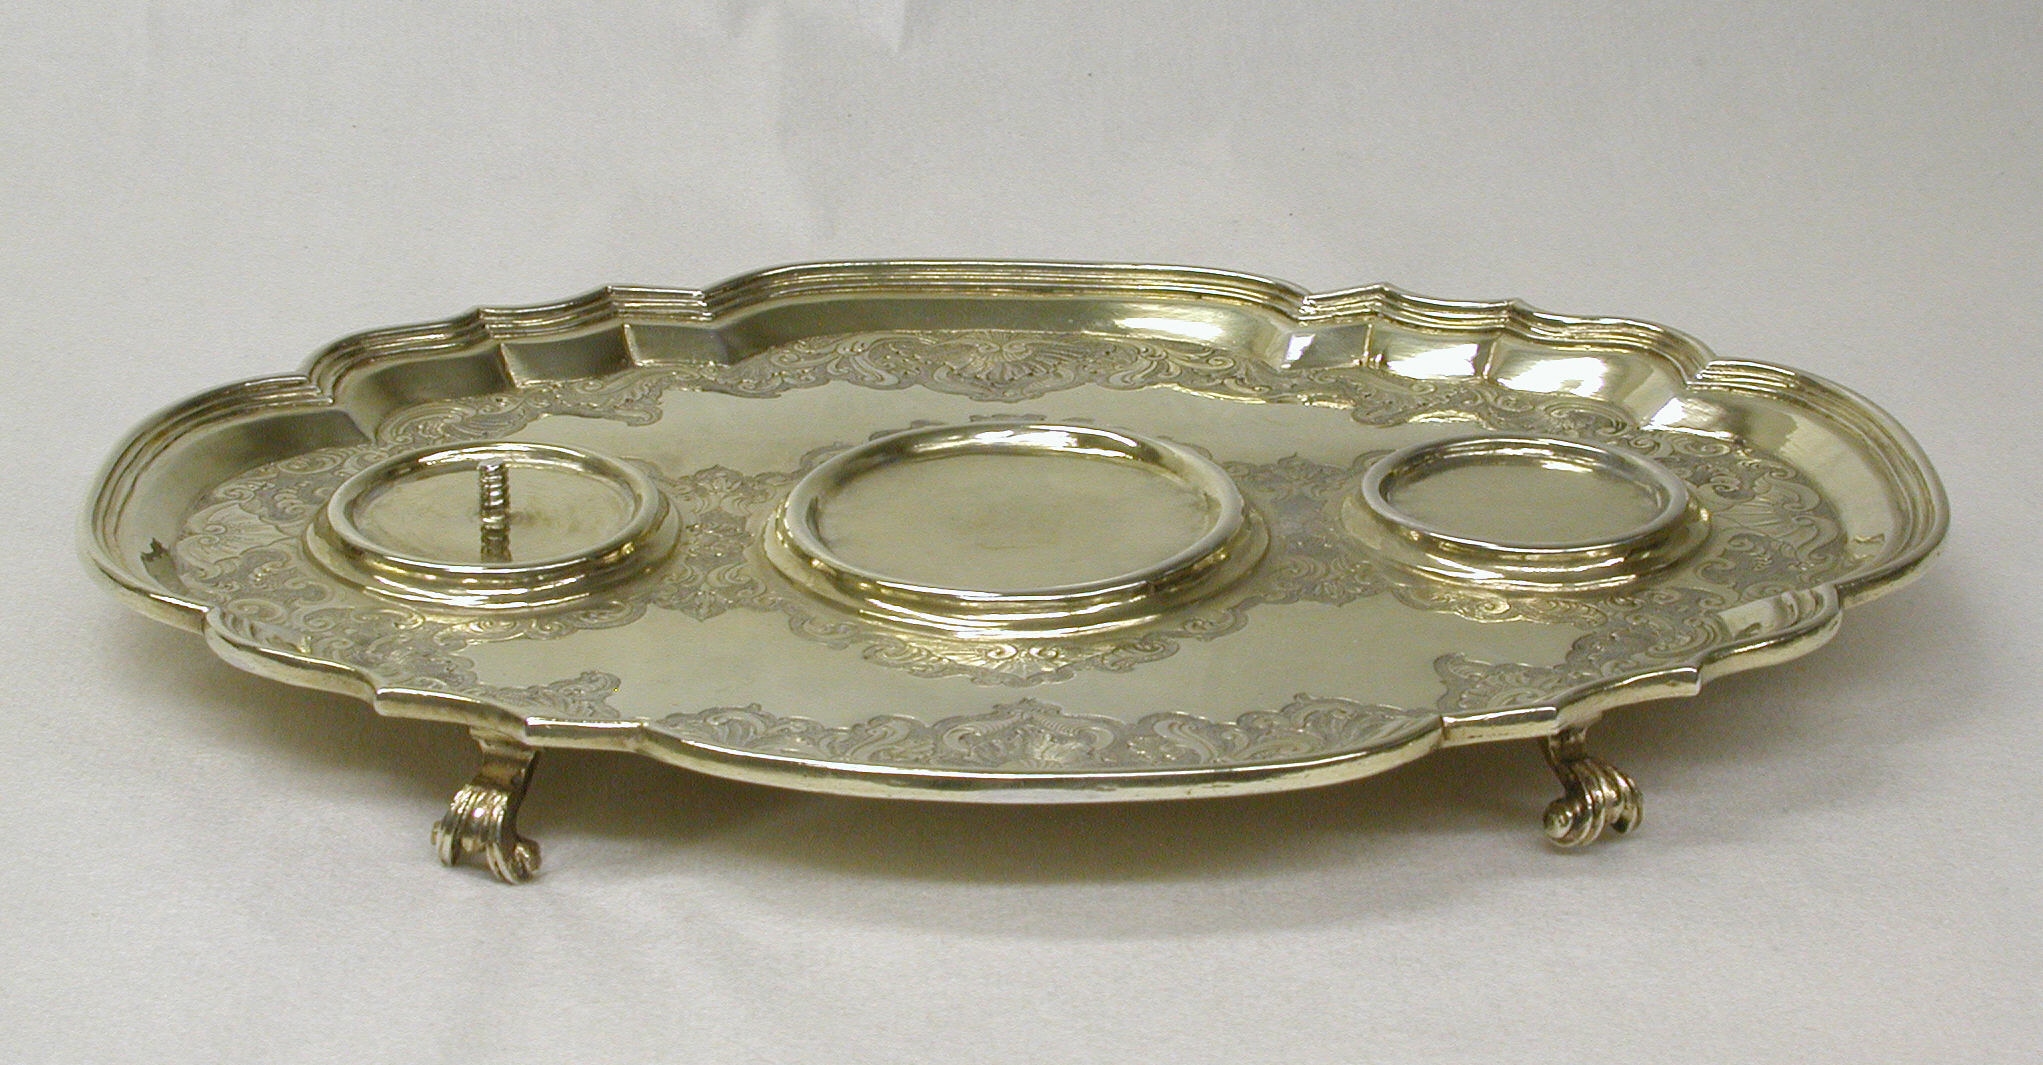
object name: tray for écritoire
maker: abraham drentwett iv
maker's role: maker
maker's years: 1711-1785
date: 1743-1745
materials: silver gilt